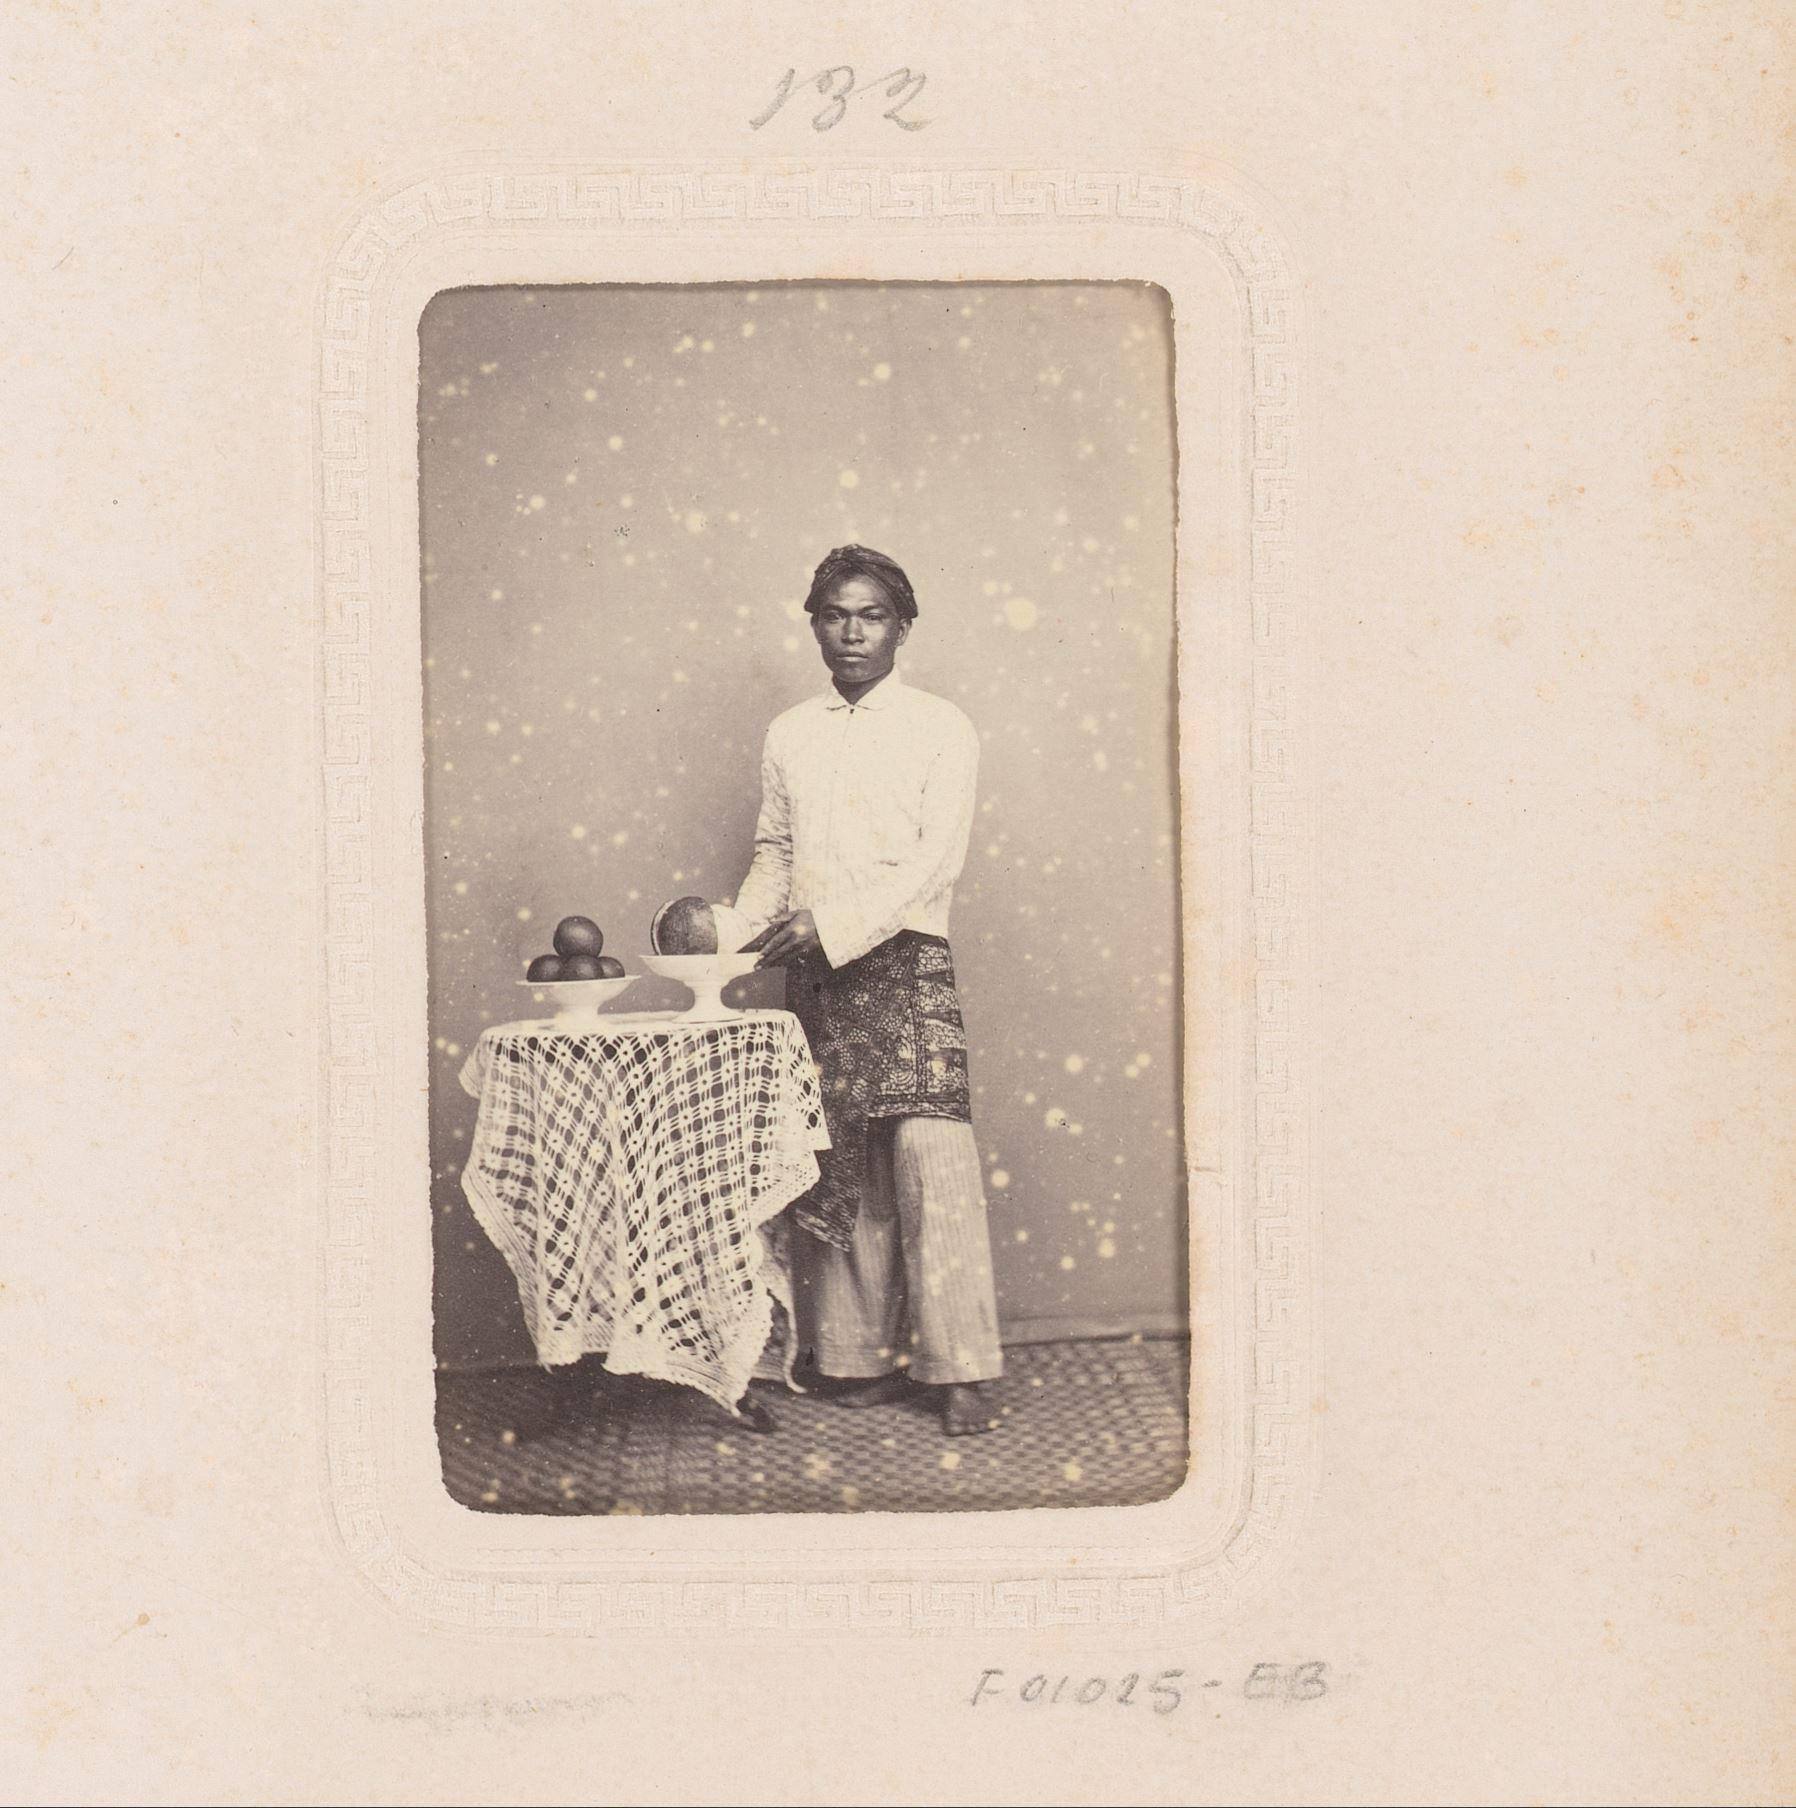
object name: carte de visite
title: Portret van een staande Indonesische man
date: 1857-1880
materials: cardboard, photographic support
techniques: albumen print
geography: java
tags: historical persons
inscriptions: inscription: ‘Woodbury & Page/ Photographers/ Java’, number: ‘132’